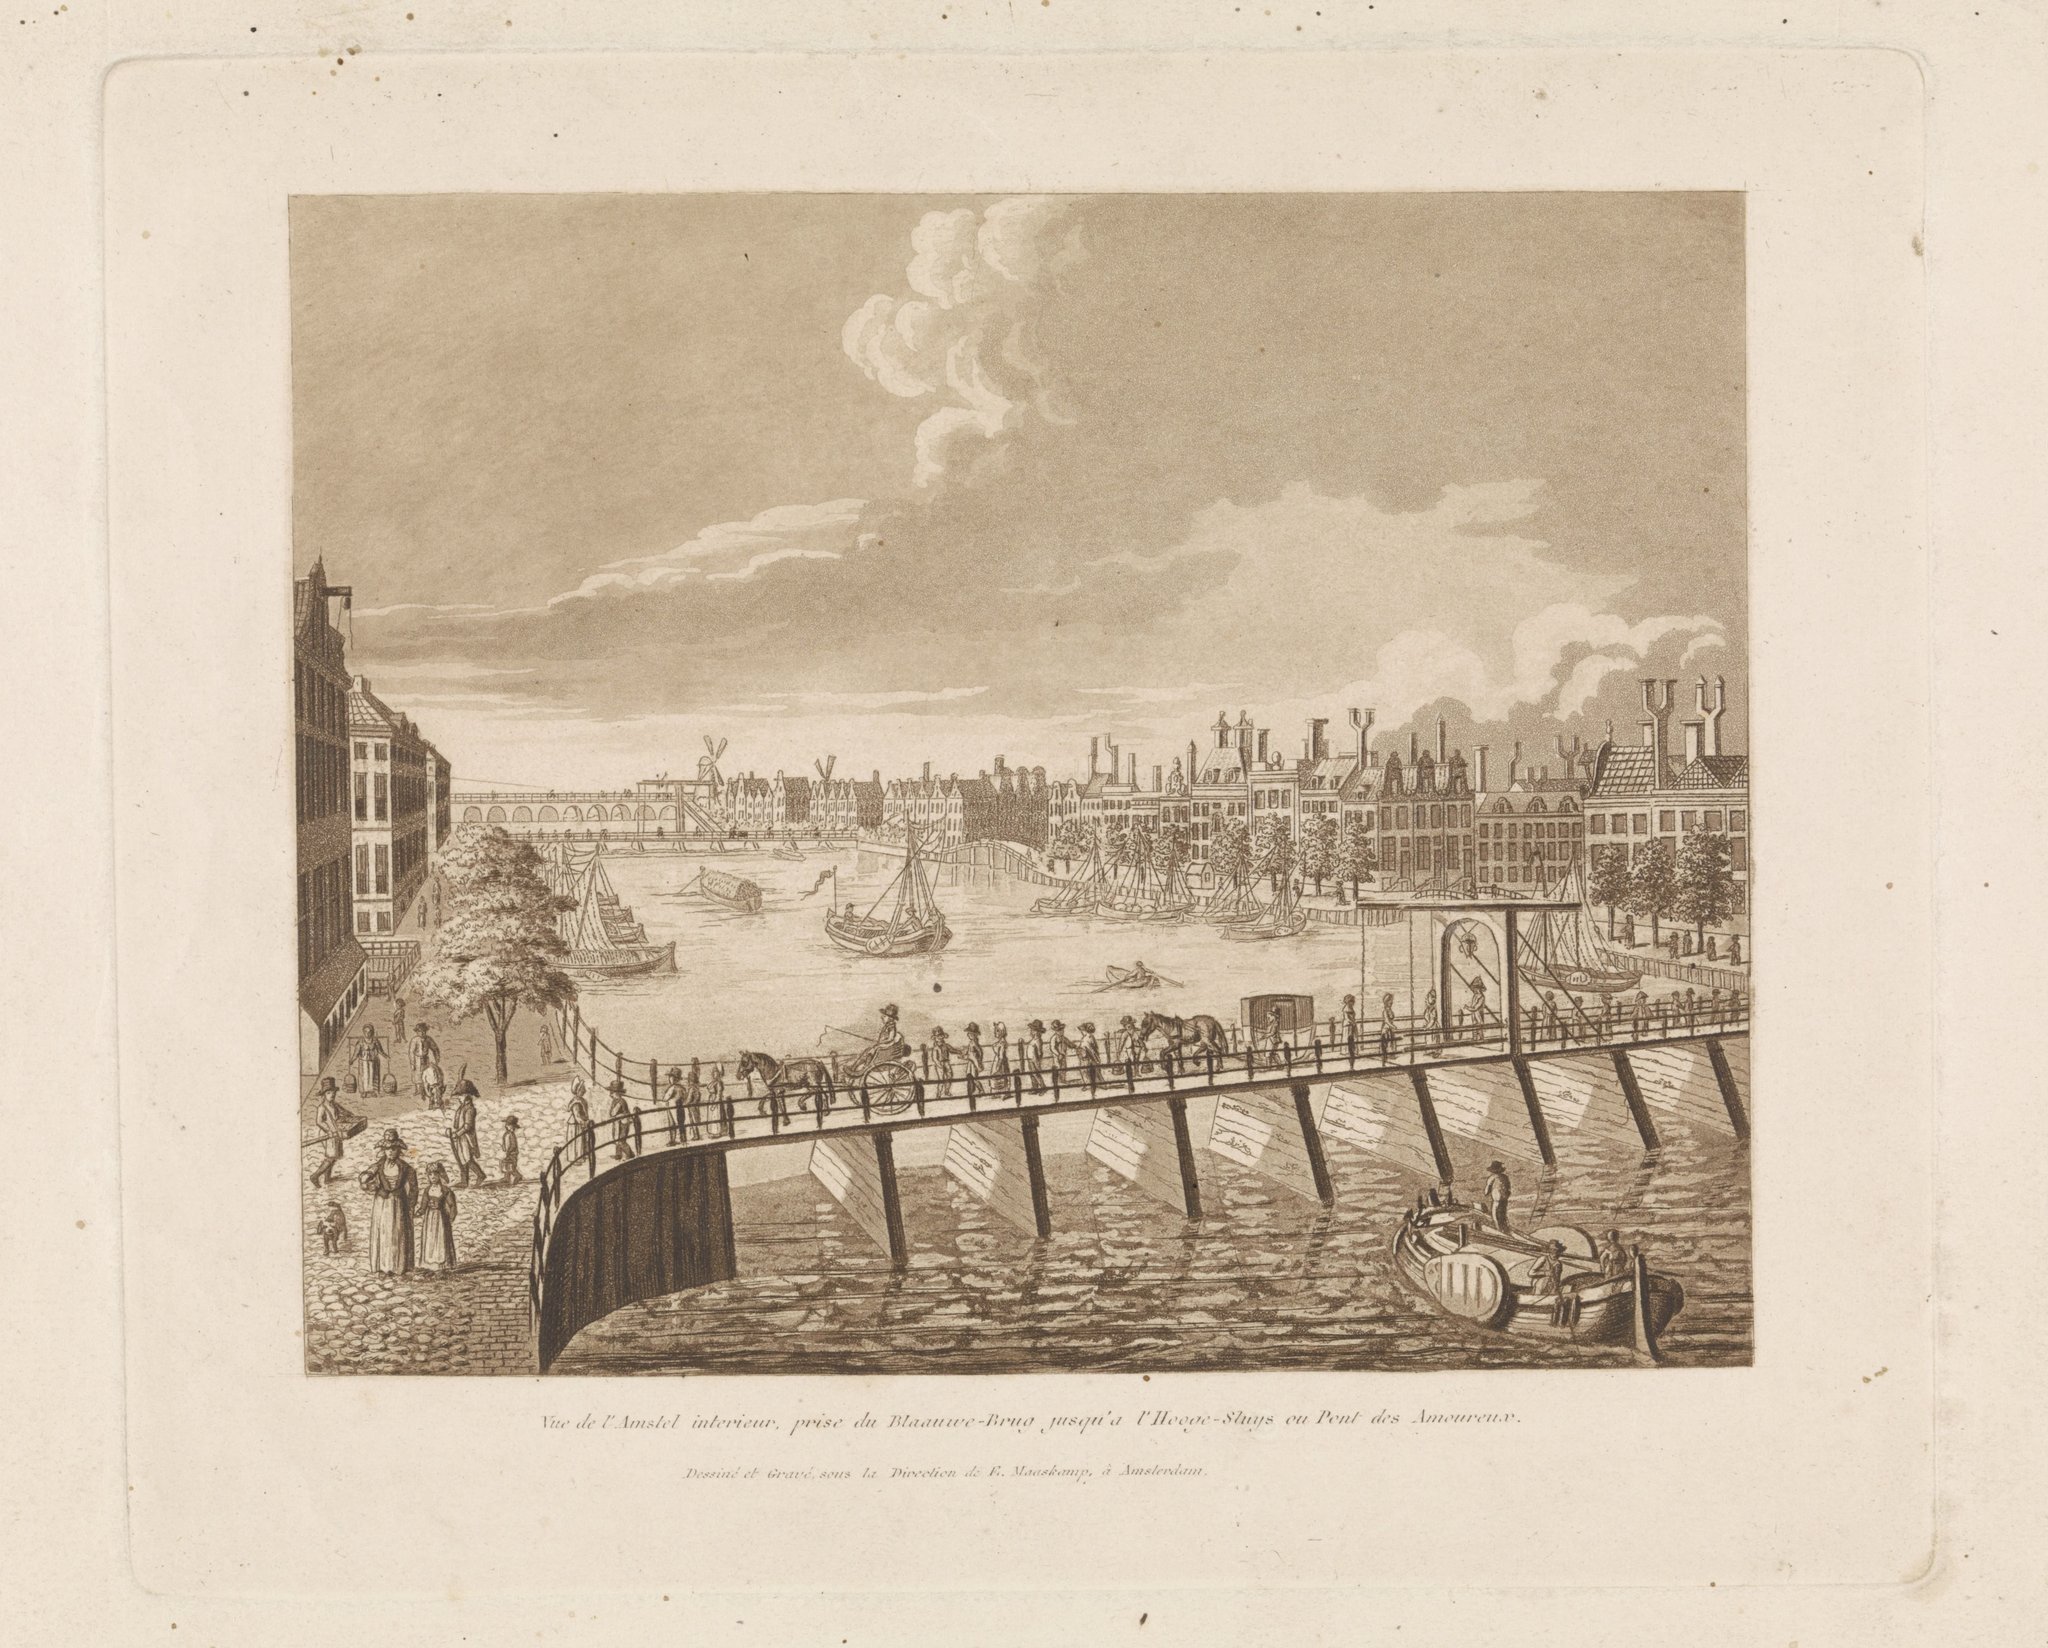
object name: print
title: Gezicht op de Binnen-Amstel, Amsterdam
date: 1824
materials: paper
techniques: aquatint, etching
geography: amsterdam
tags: bridge in city across river, canal, etc.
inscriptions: collector's mark: Lugt 2228, inscription: ‘as’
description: Prent ook gebruikt in: Maaskamp, Evert. Tableau des principales vues des palais et édifices : représentations et descoutumes et usages, dans les provinces septentrionales du Royaume des Pays-Bas. Amsterdam: Evert Maaskamp, 1824.